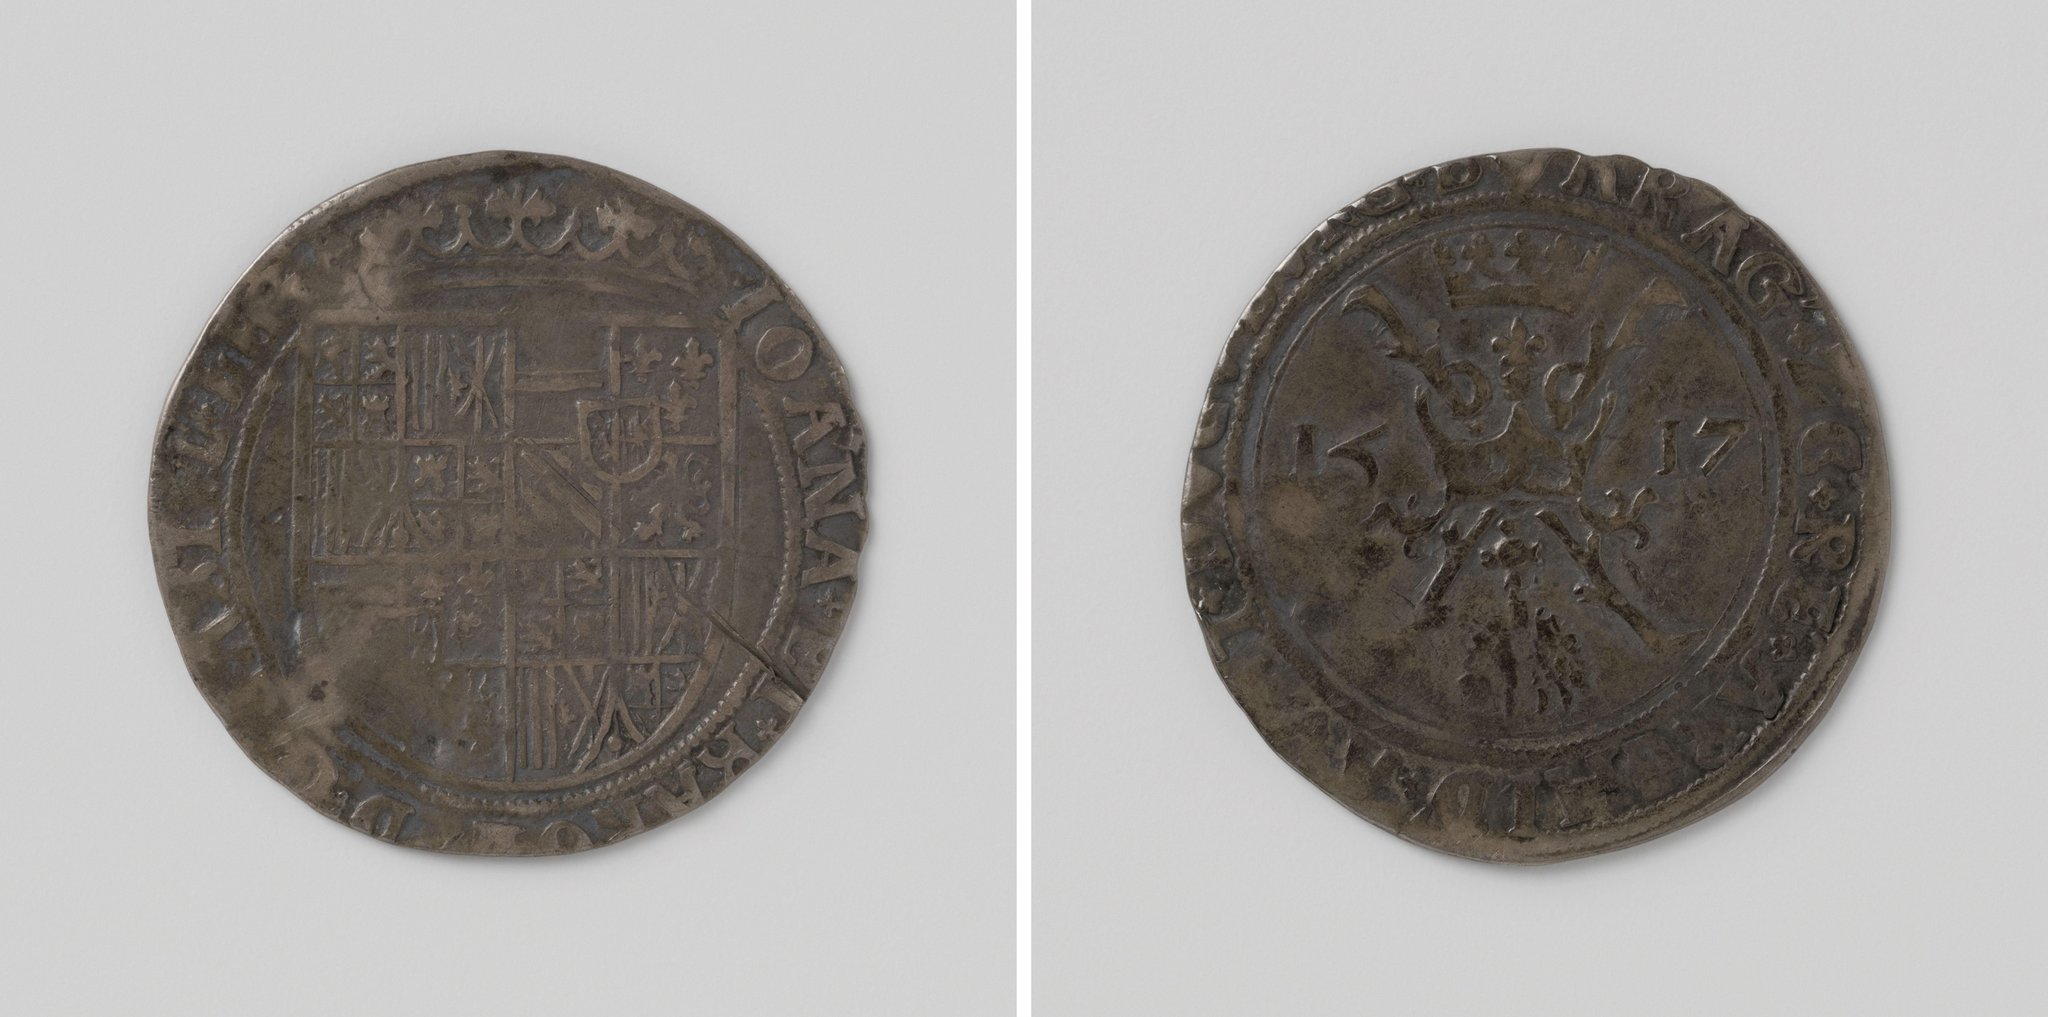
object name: coin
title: Spaanse reaal van Karel en Johanna, koning en koningin van Castilie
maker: Anonymous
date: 1517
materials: silver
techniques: striking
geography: antwerp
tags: ghent, charles v (holy roman emperor and king of spain)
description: Voorzijde: gekroond wapenschild binnen omschrift. Keerzijde: vuurslag, waaraan Gulden Vlies hangt, op Bourgondisch kruis, tussen jaartal binnen omschrift